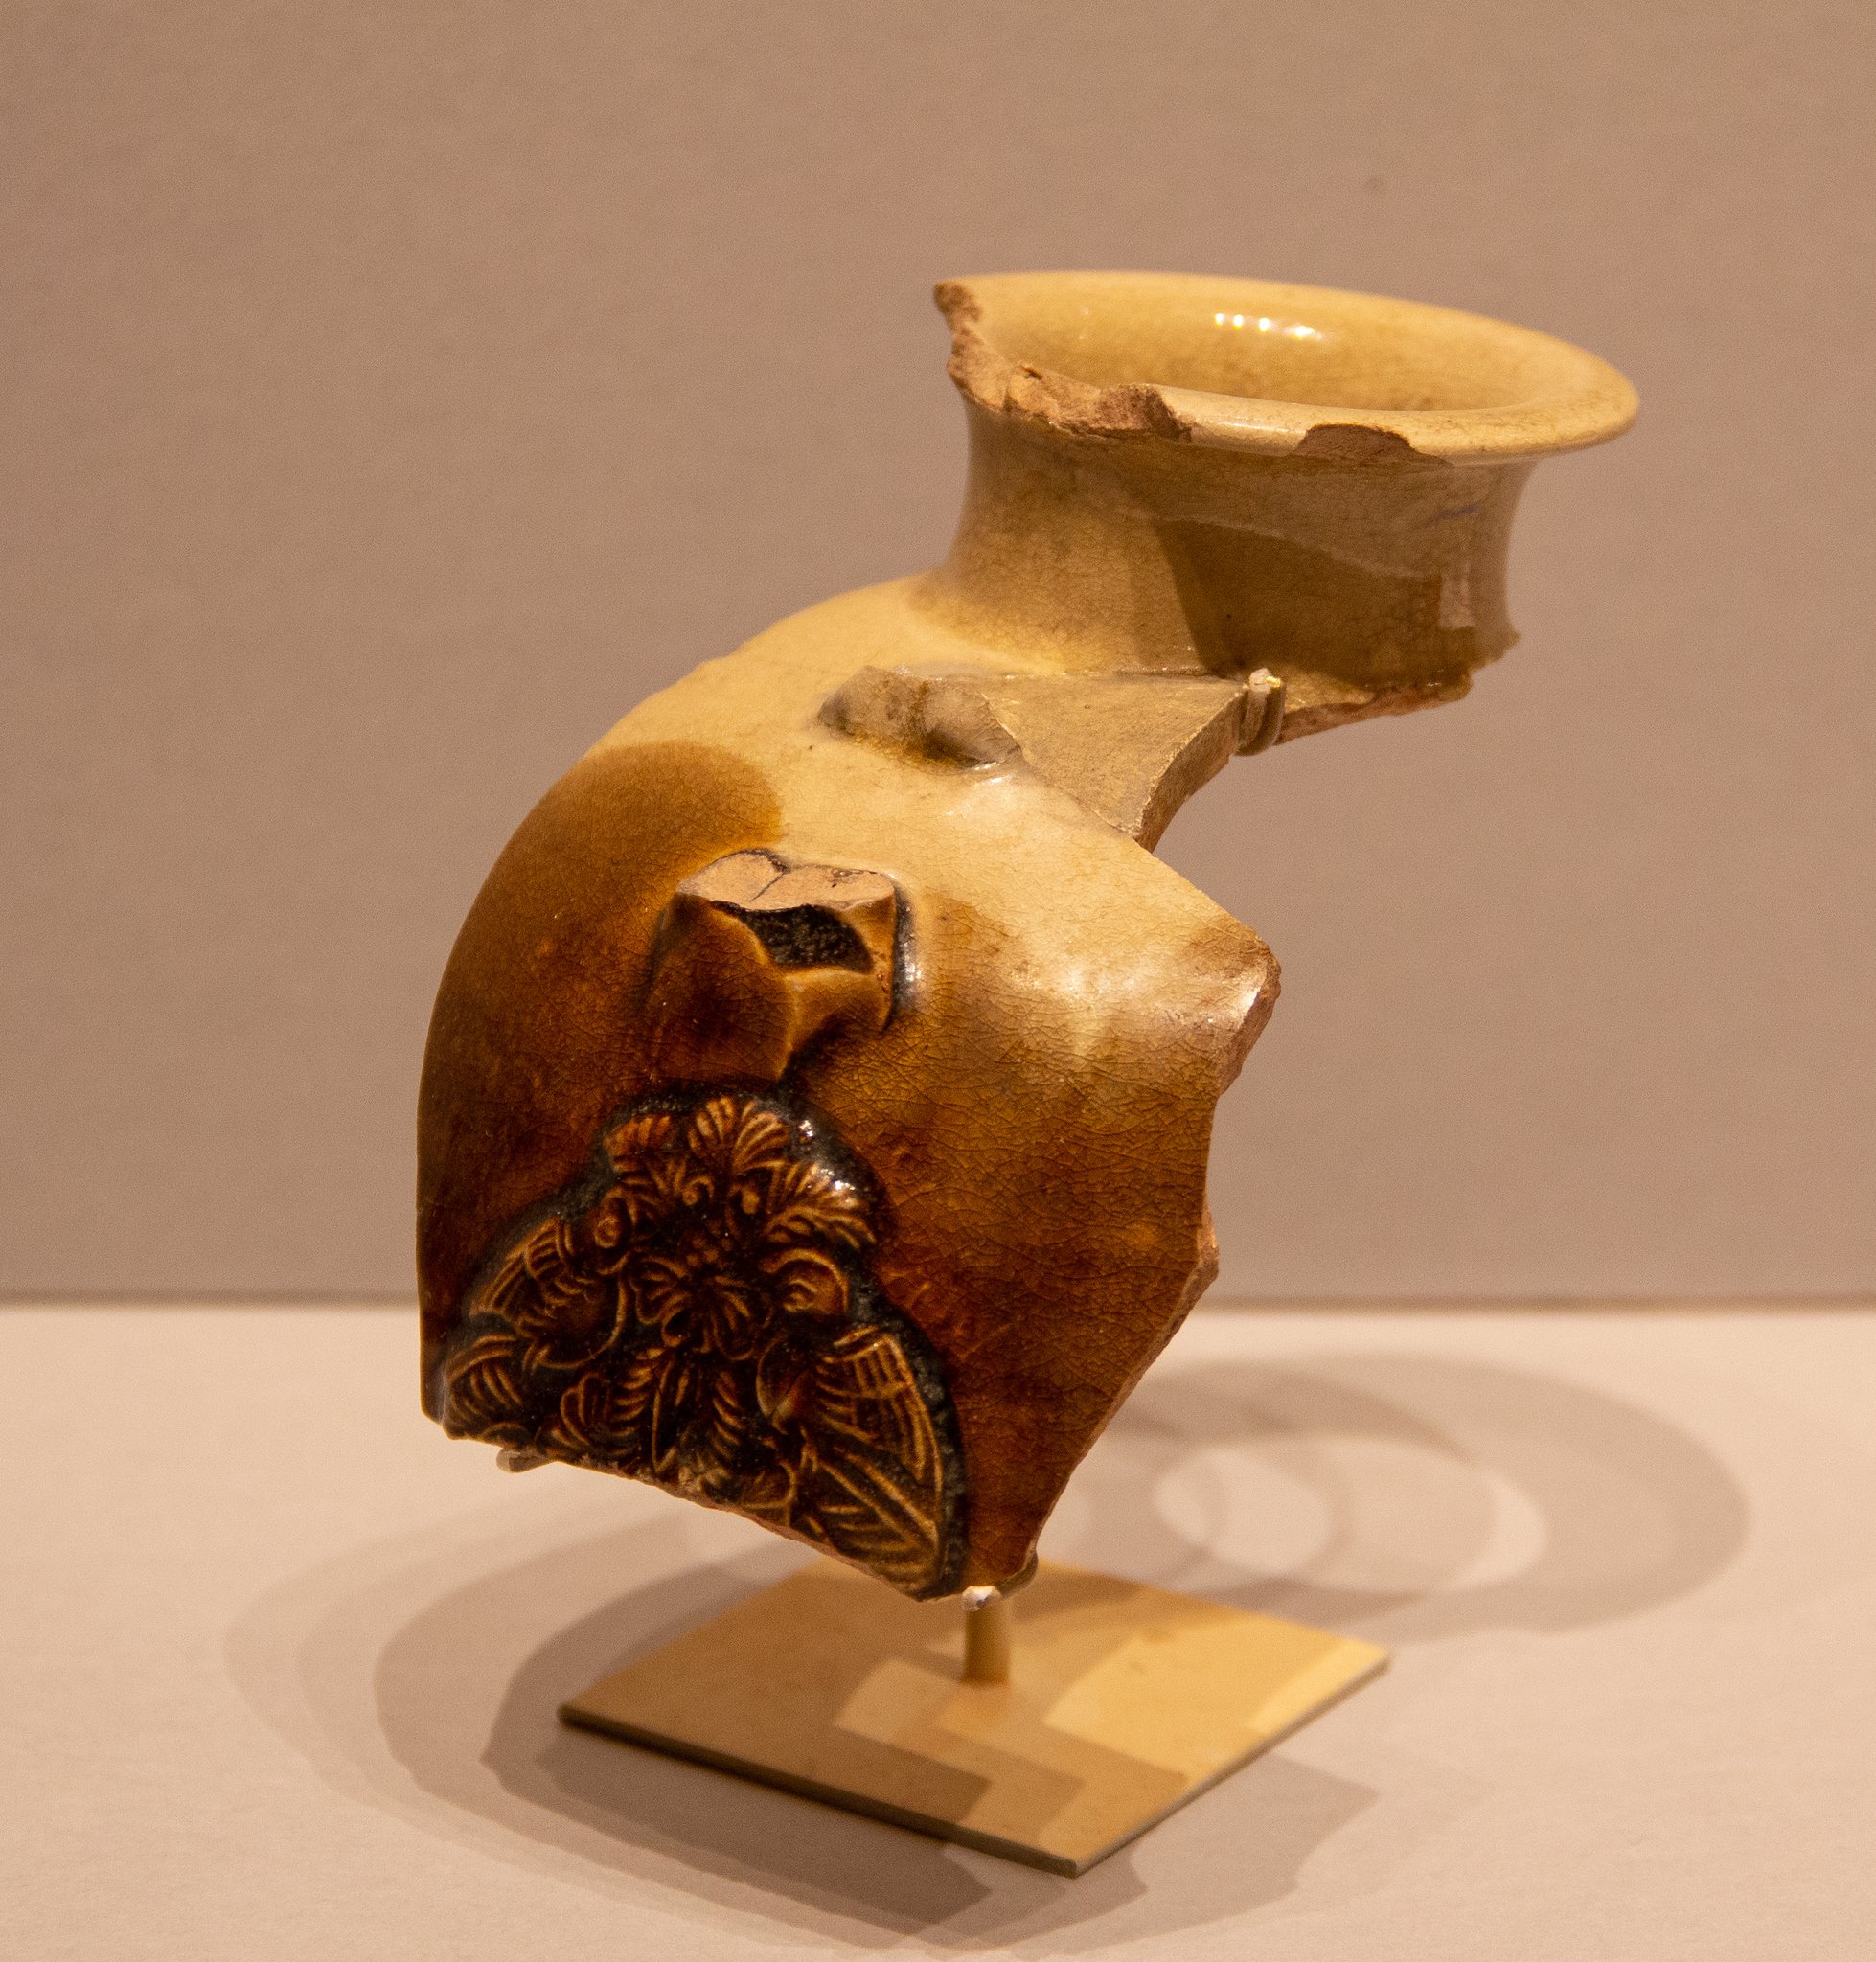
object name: fragment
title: Fragment of an Imported Chinese Ewer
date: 801-900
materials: earthenware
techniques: glazing, molding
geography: china